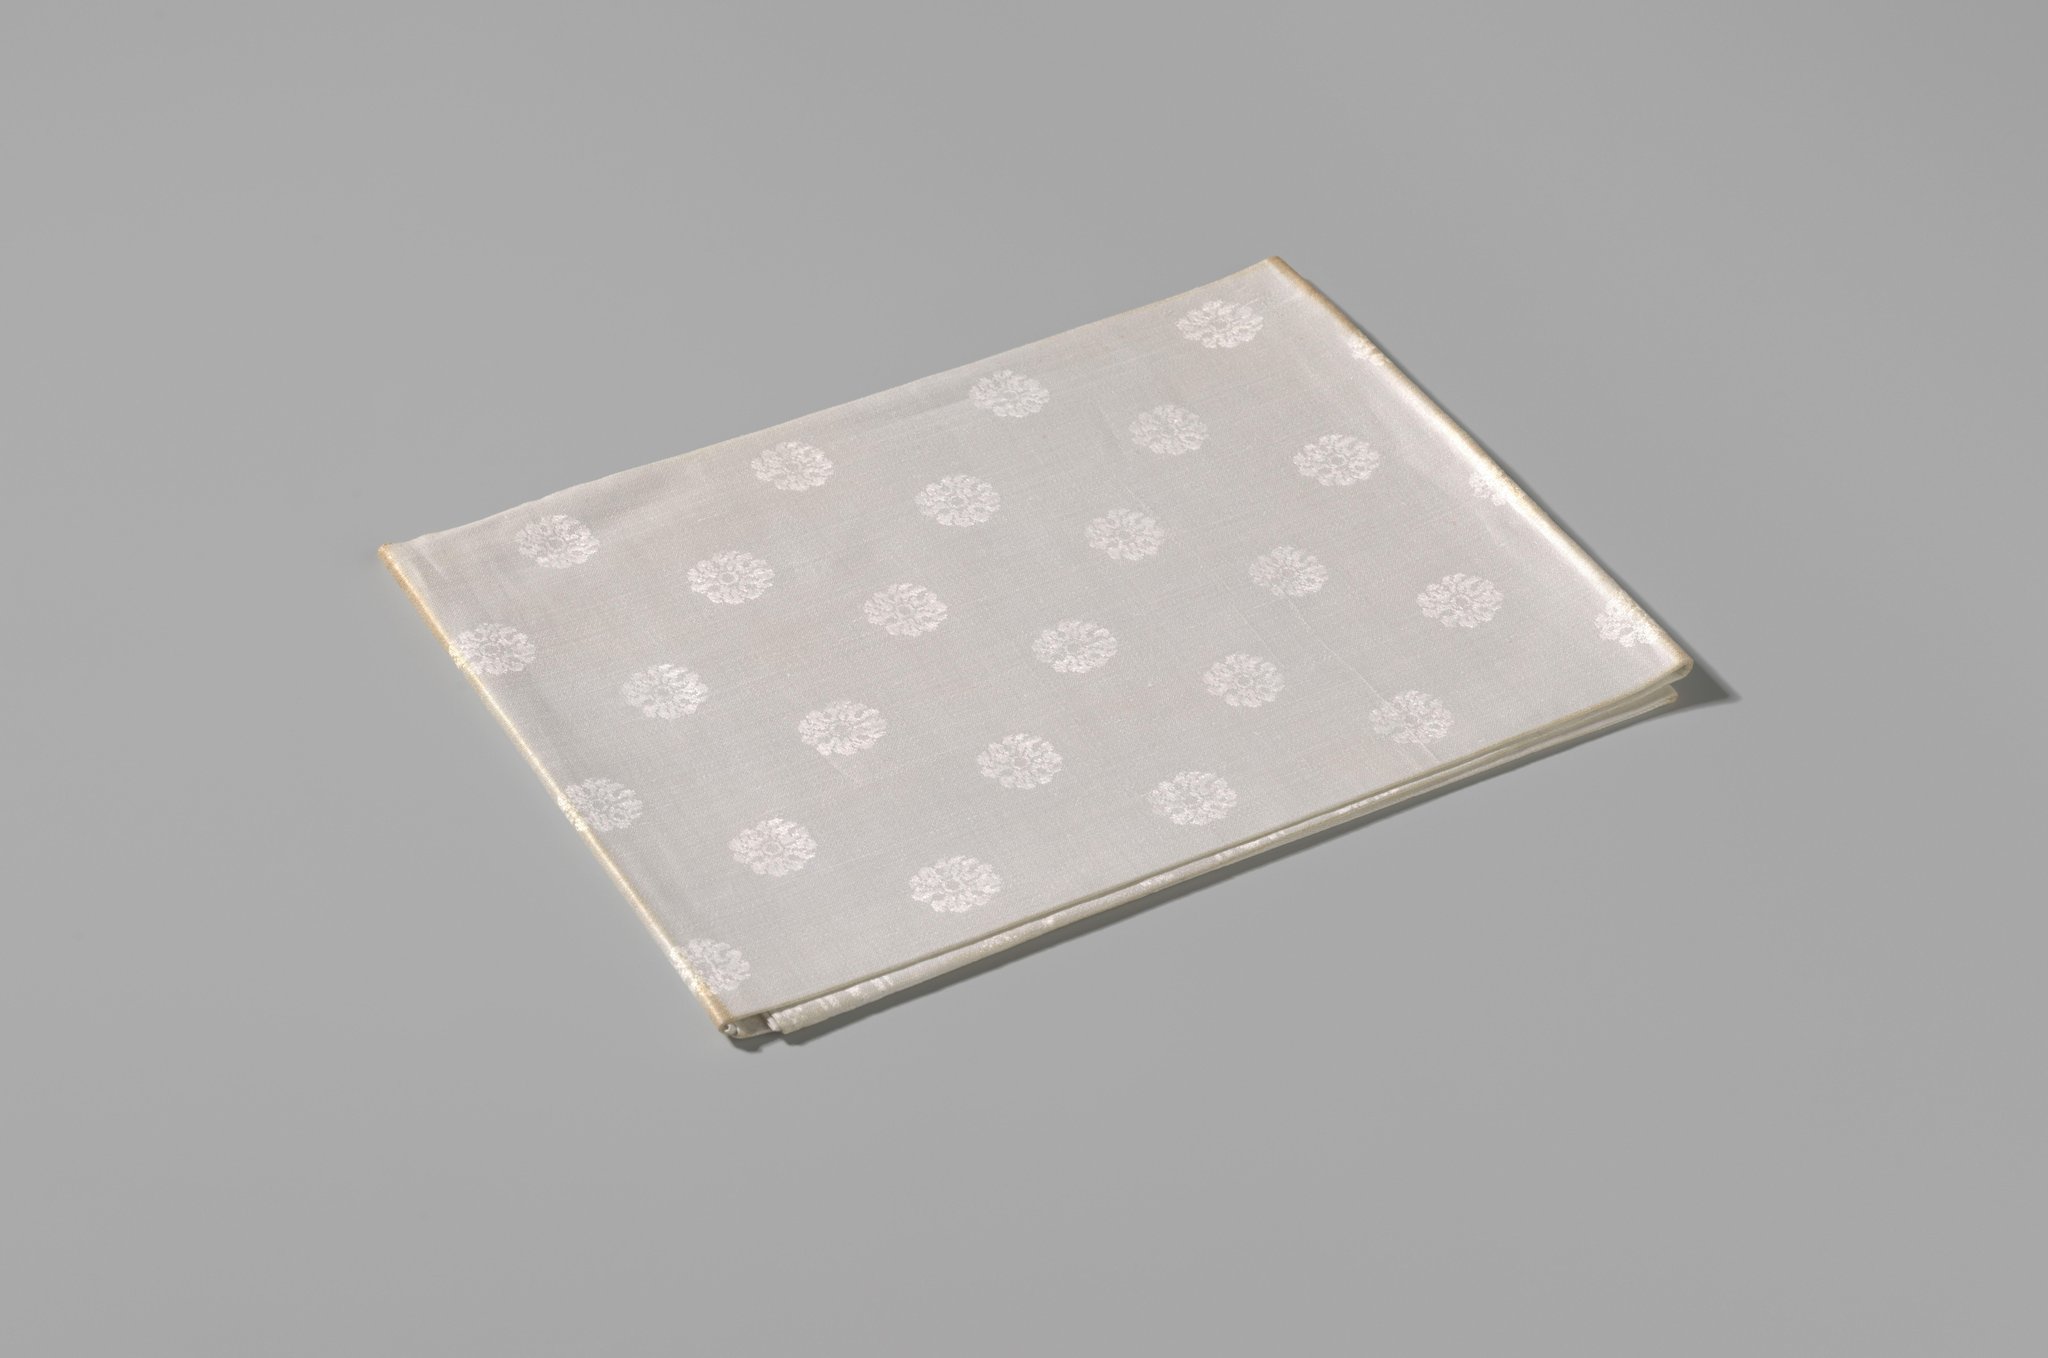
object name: napkin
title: Servet met patroon van rozetten en rozentakken. Merk 100 en HW.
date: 1780-1800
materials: linen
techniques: damask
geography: northern netherlands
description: Wit linnendamasten servet met een patroon van rozetten en rozentakken, merk 100 en HW 30.